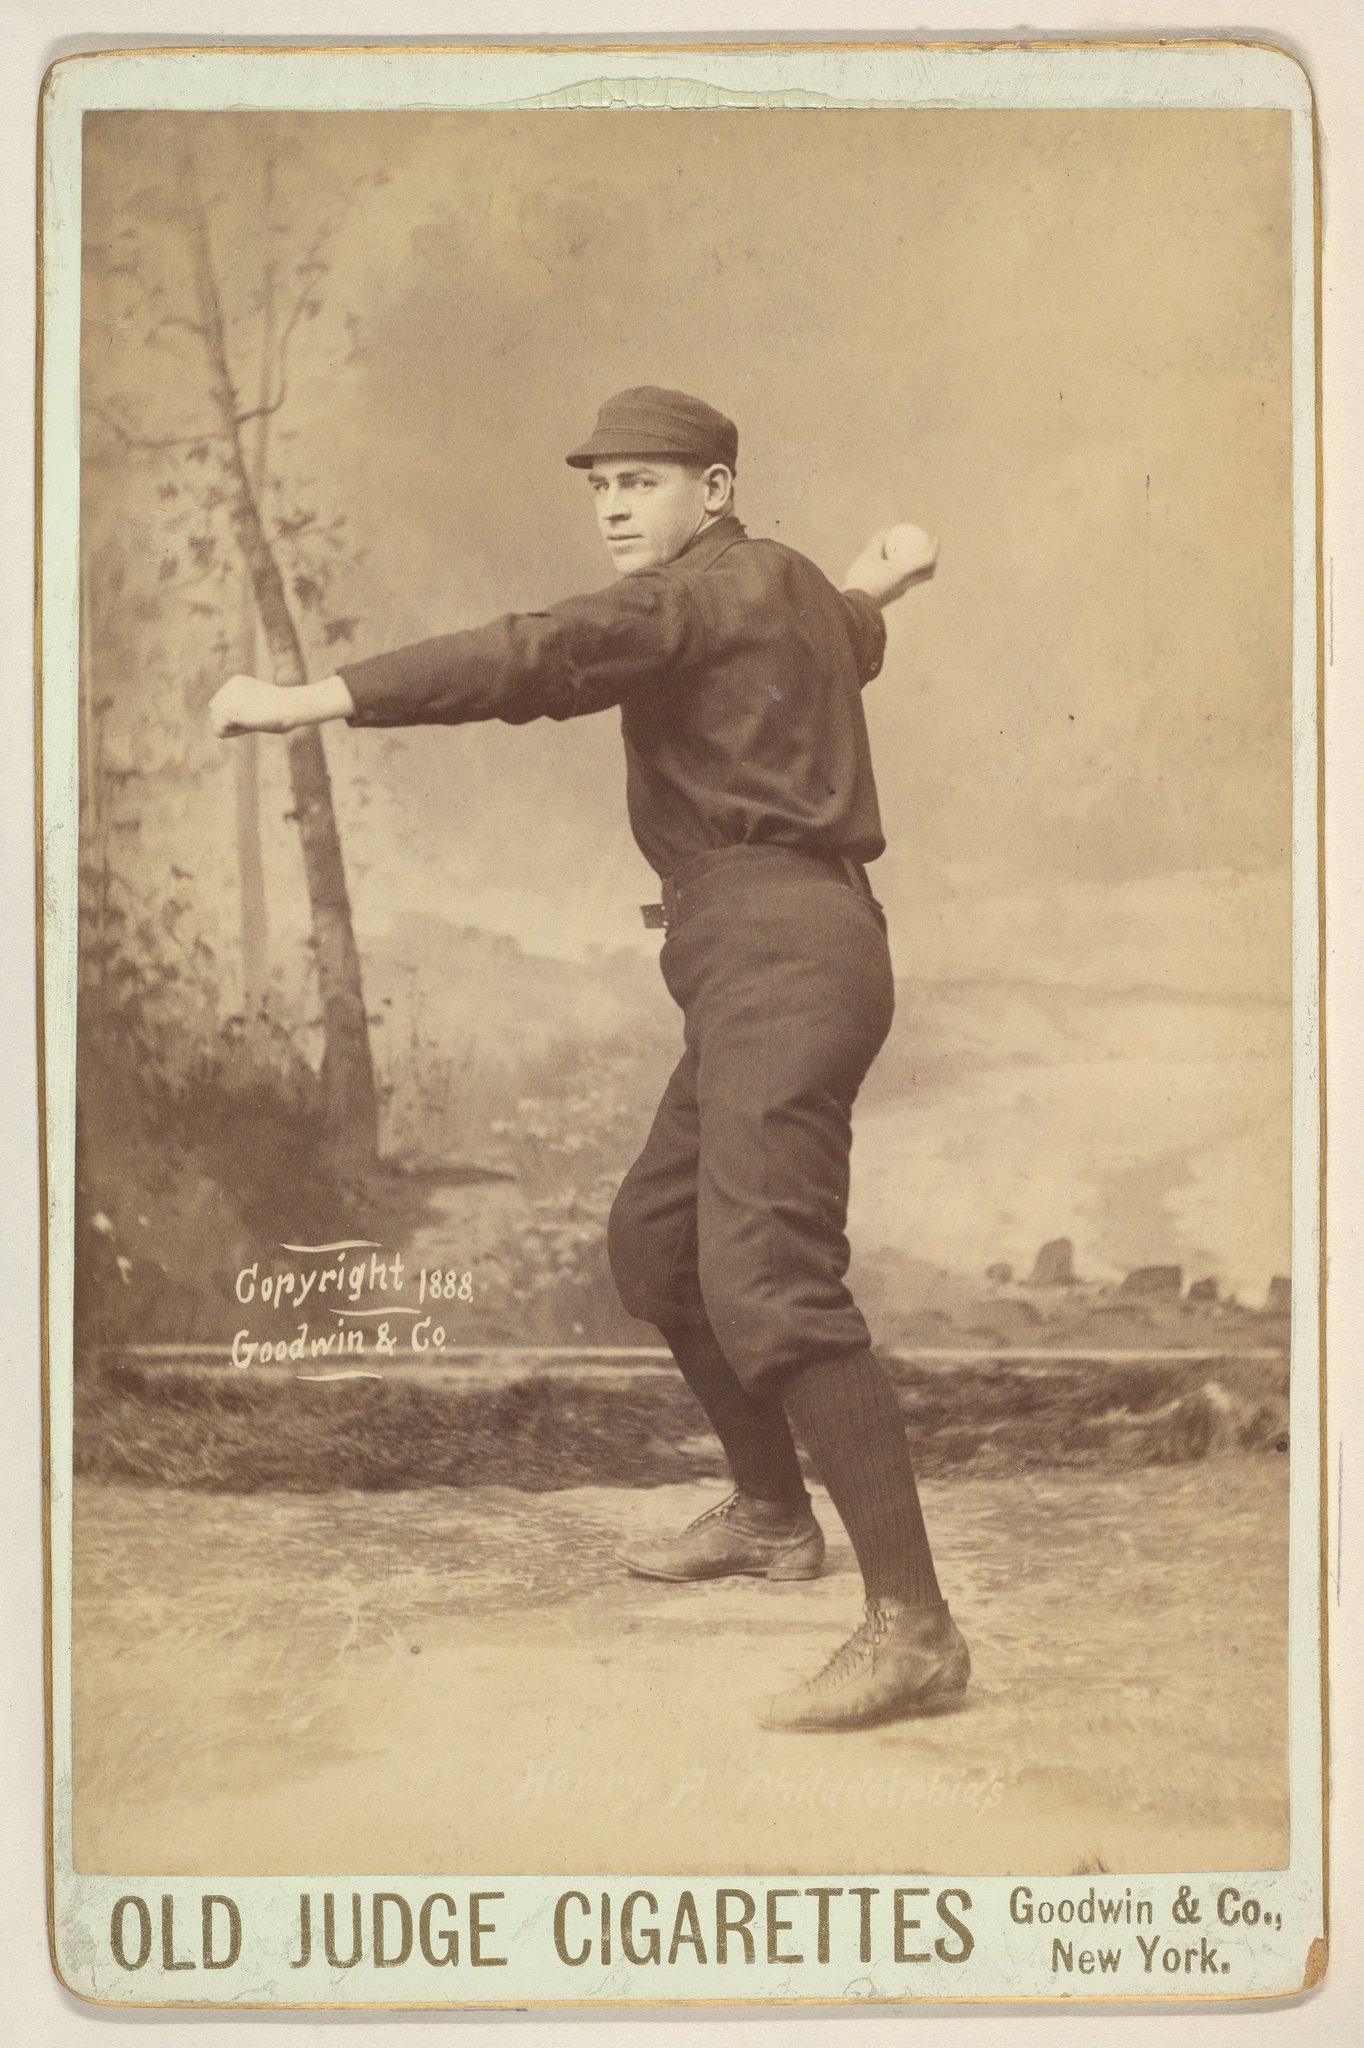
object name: baseball card, photograph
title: Henry, Pitcher, Philadelphia, from the series Old Judge Cigarettes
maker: goodwin & company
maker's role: publisher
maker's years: 1850-1950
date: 1888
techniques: albumen silver print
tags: men,portraits,baseball,athletes